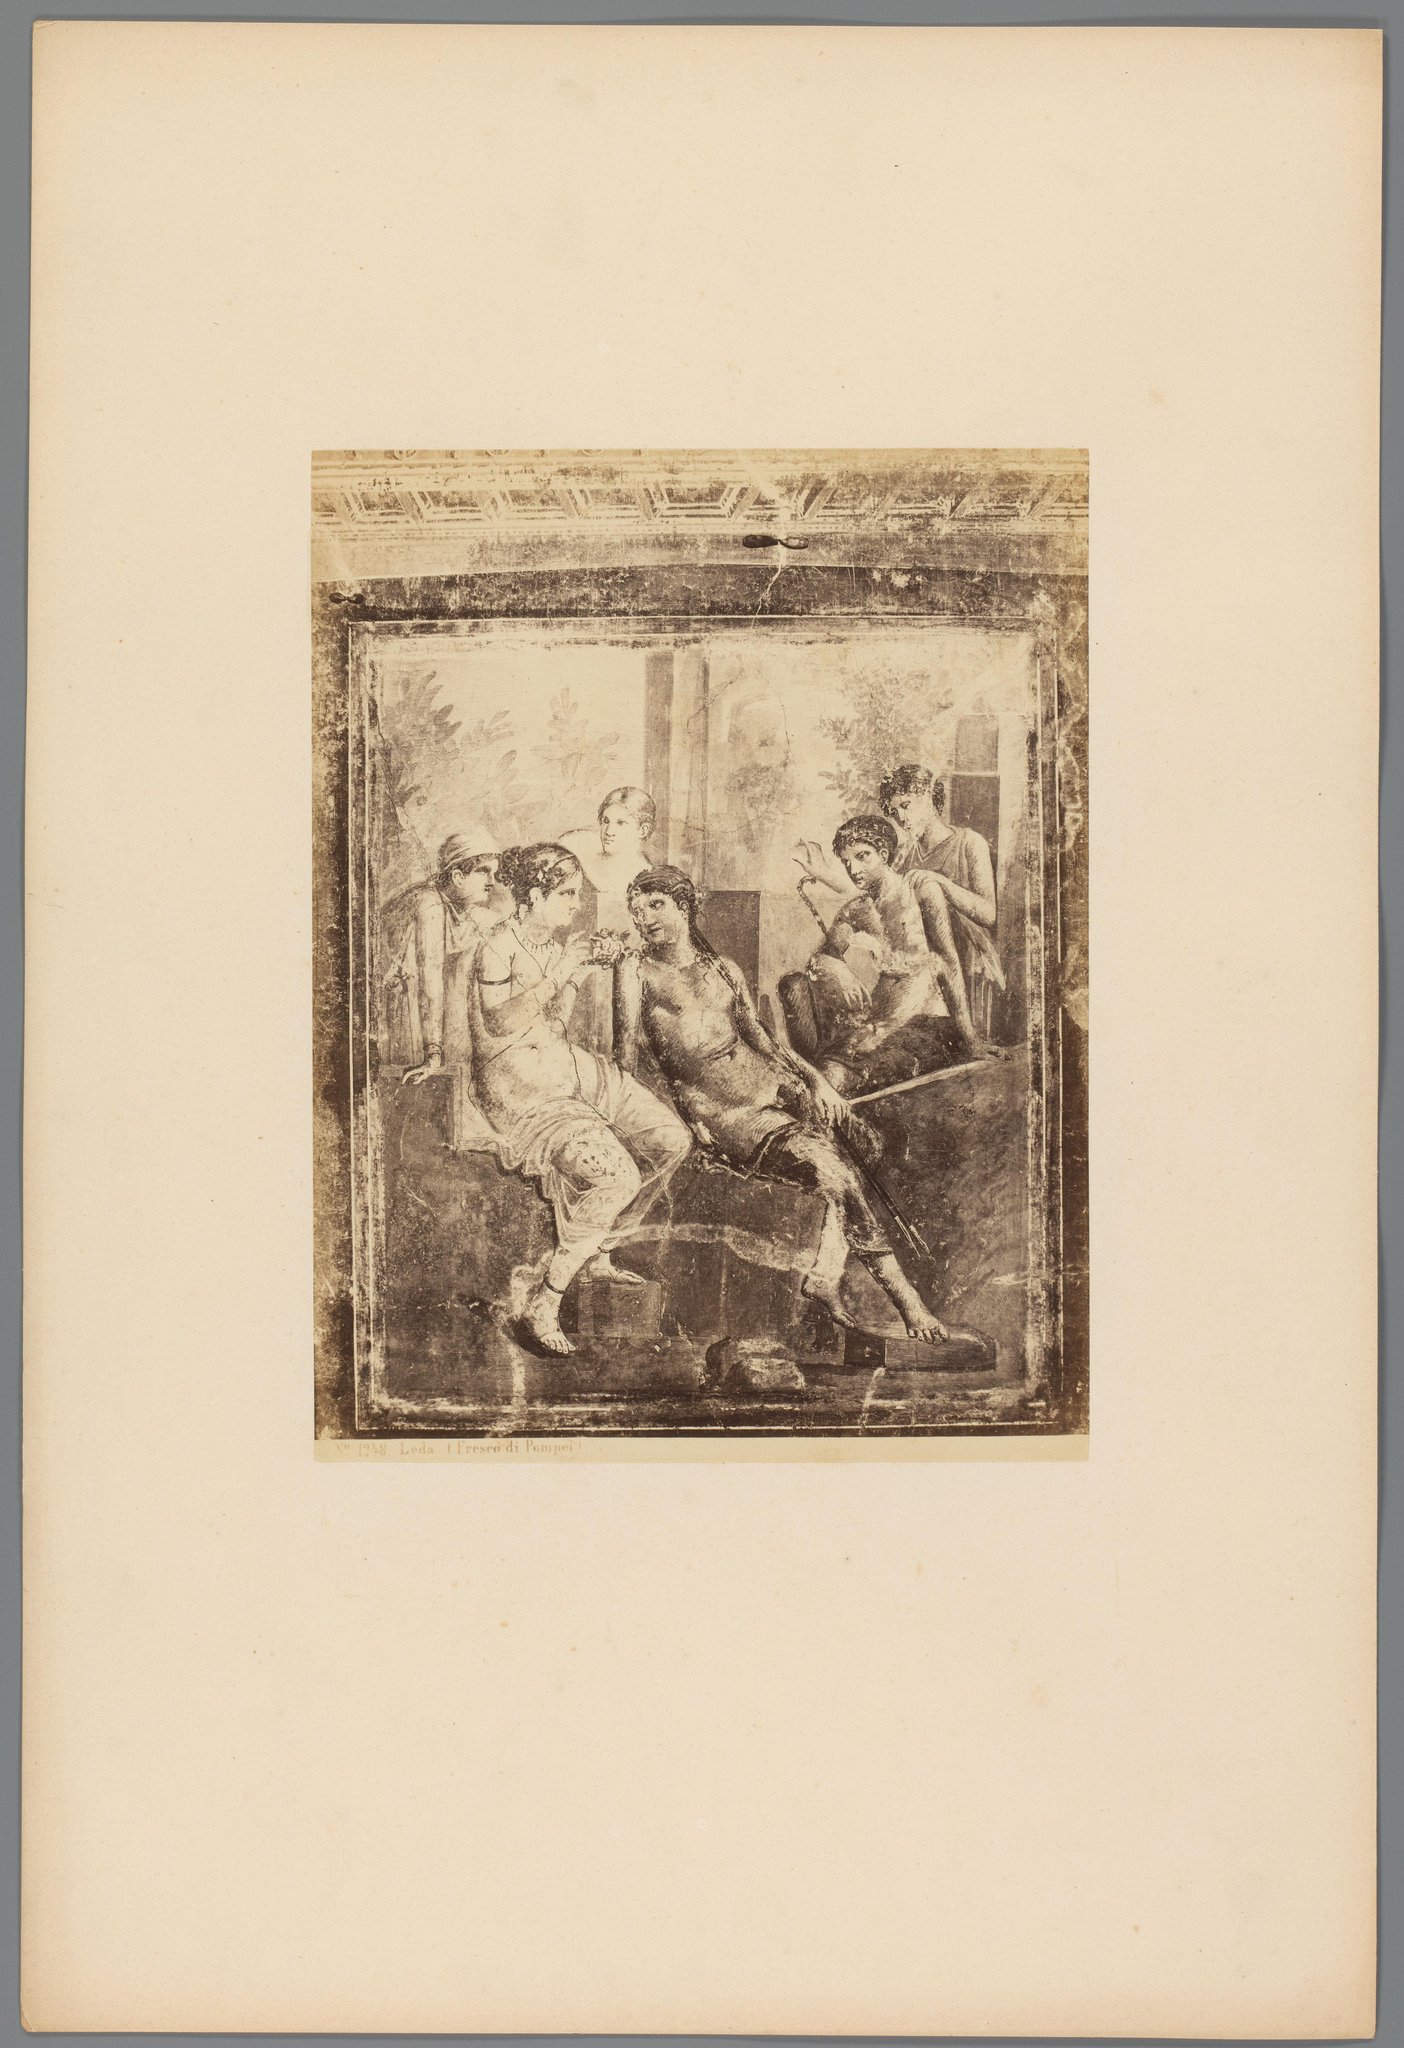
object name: reproduction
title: Fotoreproductie van een fresco te Pompeï, Italië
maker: Anonymous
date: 1851-1900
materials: cardboard, paper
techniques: albumen print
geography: pompeii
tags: wall-covering, pompeii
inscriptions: number: ‘No. 1248.’